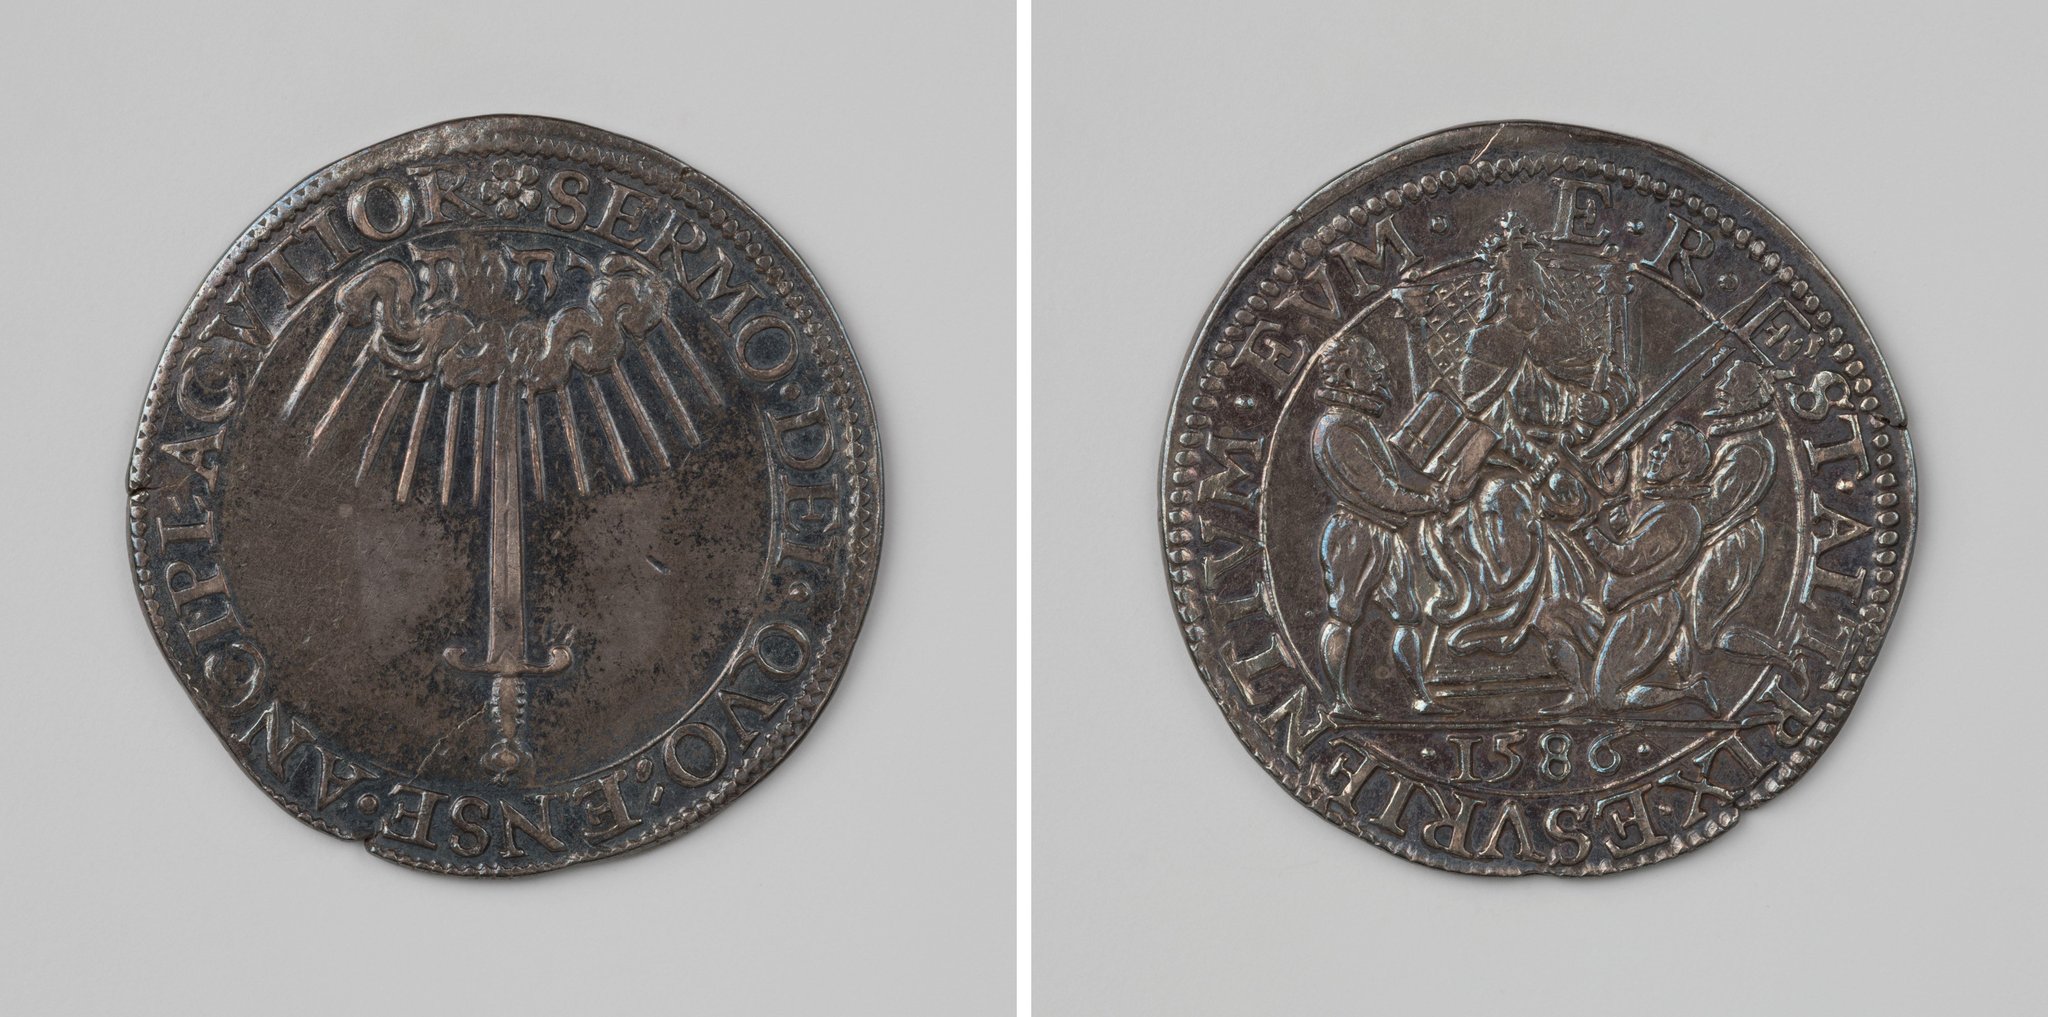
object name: jeton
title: Engelse hulp aan de opstandelingen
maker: Anonymous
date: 1586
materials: silver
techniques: striking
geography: dordrecht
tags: greenwich, richmond (surrey), koningin, elizabeth i tudor (koningin van engeland), tachtigjarige oorlog